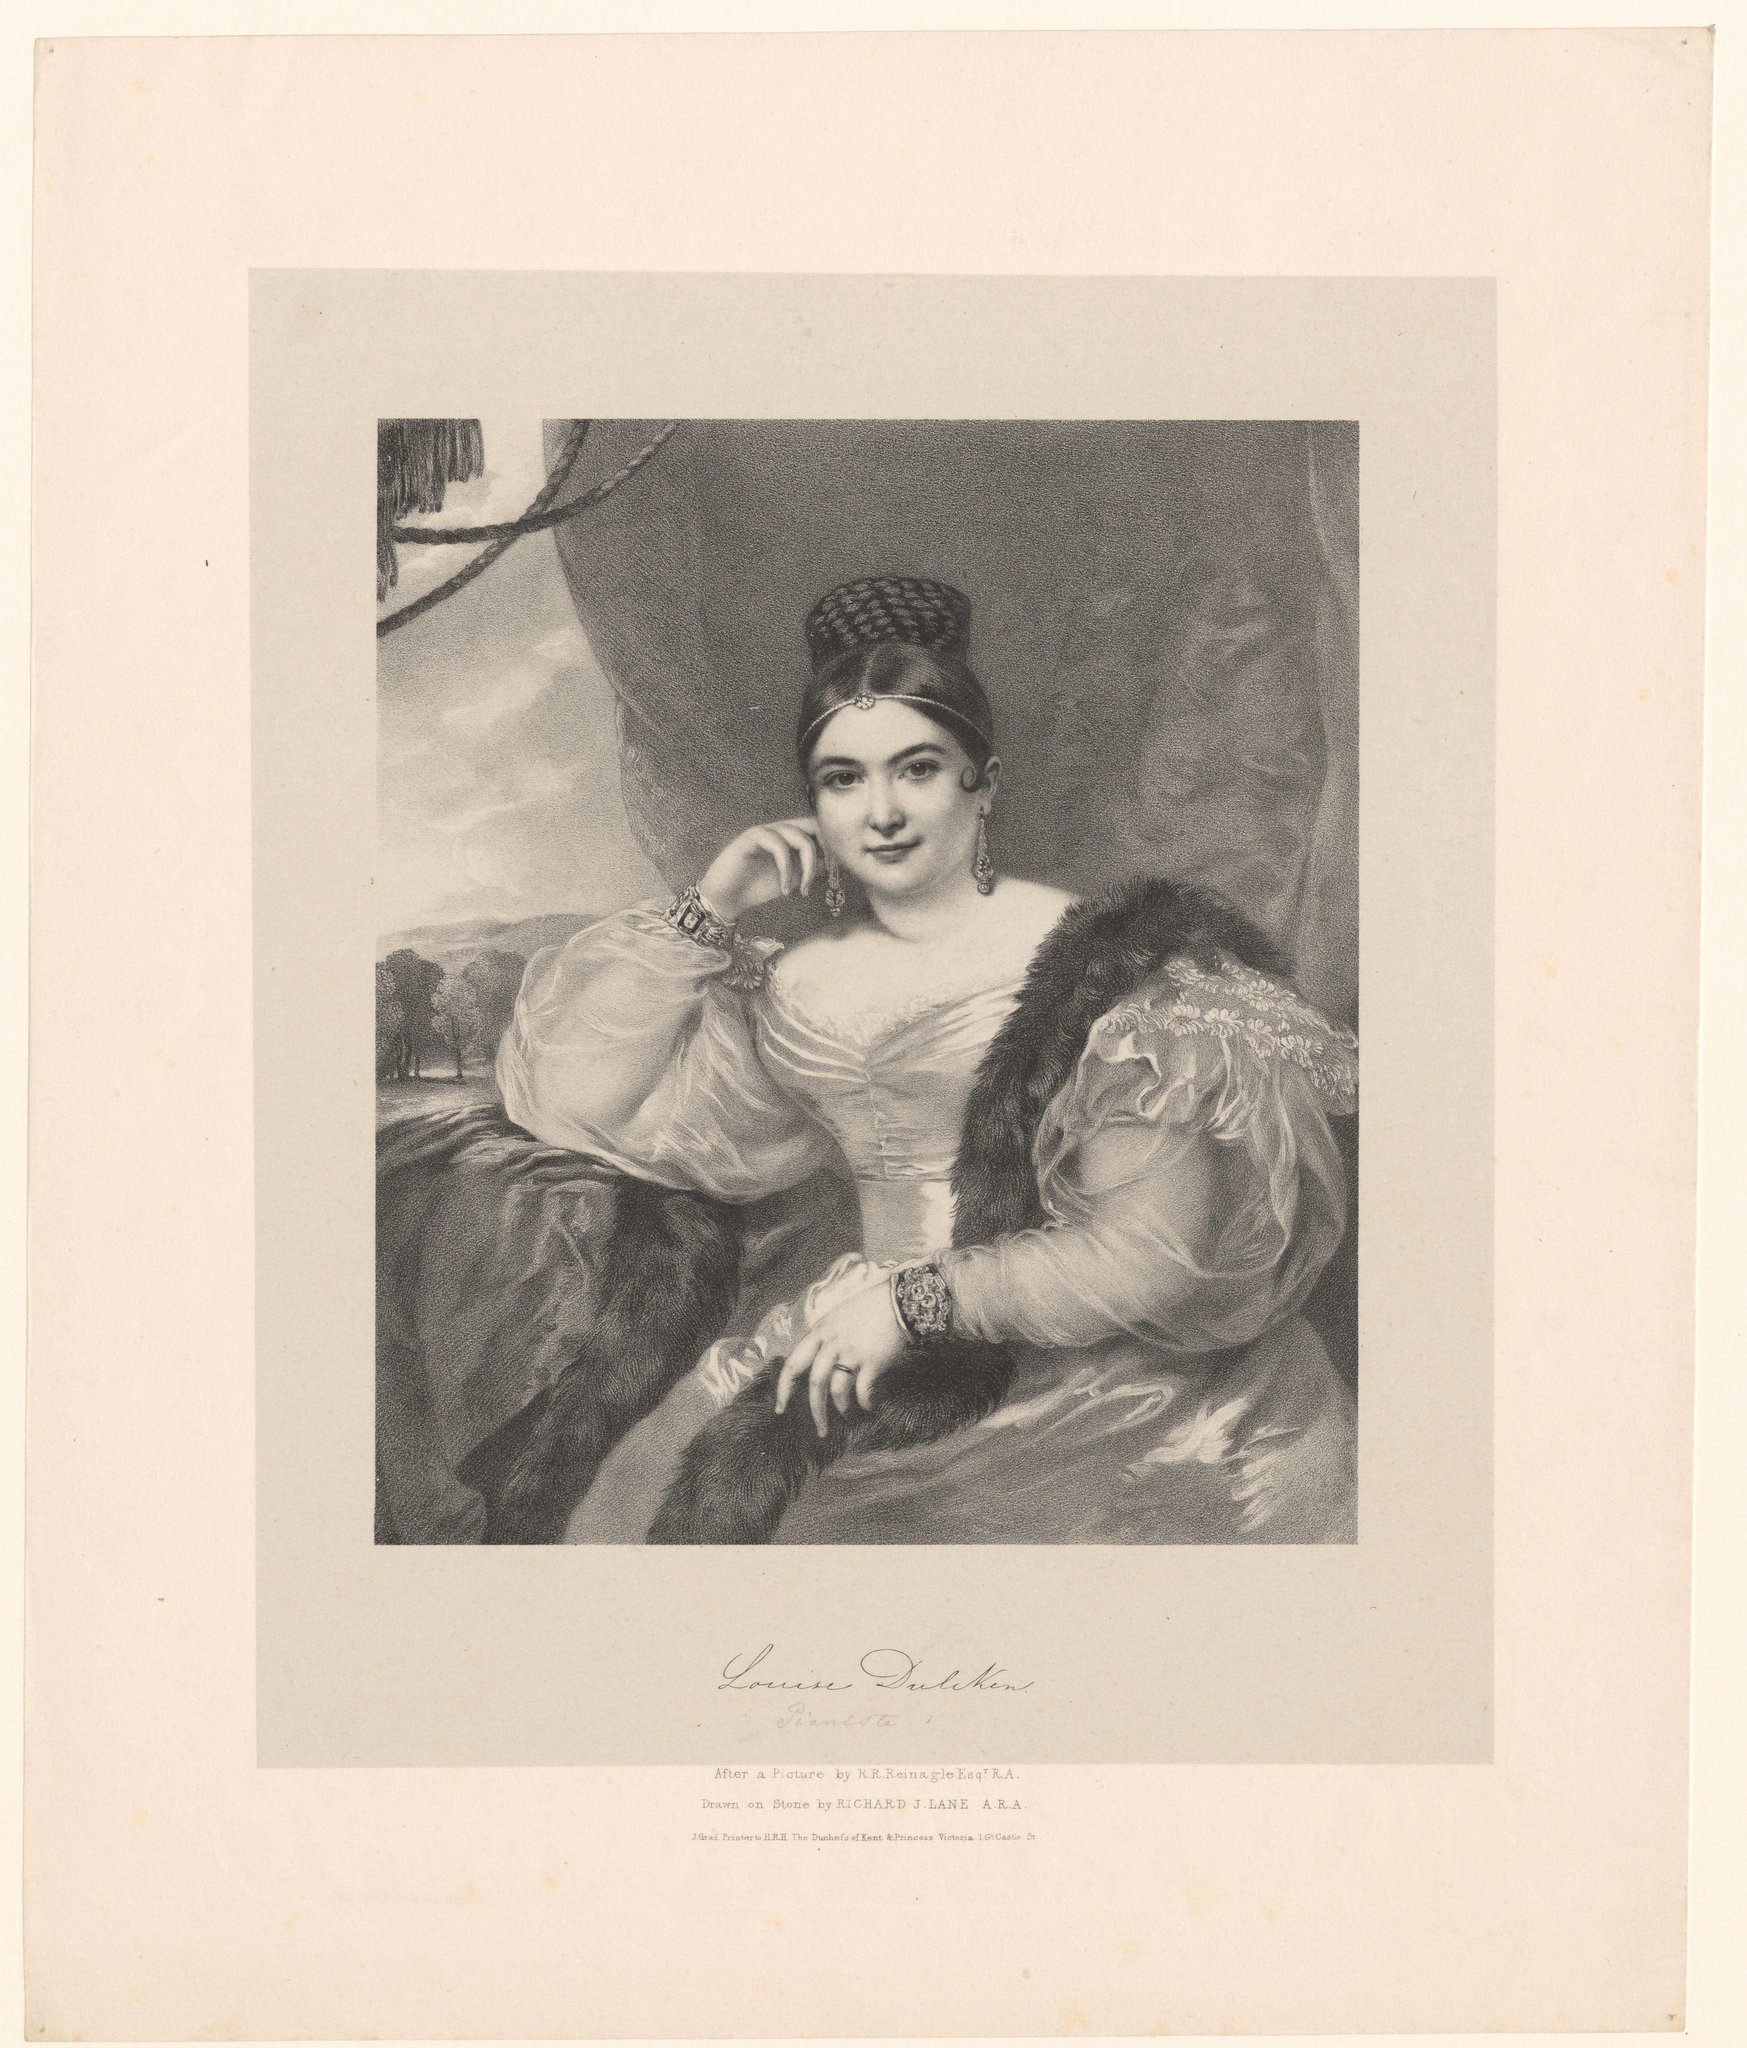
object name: print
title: Louise Dulcken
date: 1820-1872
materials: paper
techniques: lithograph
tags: adult woman, historical persons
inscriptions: collector's mark: Lugt 2228